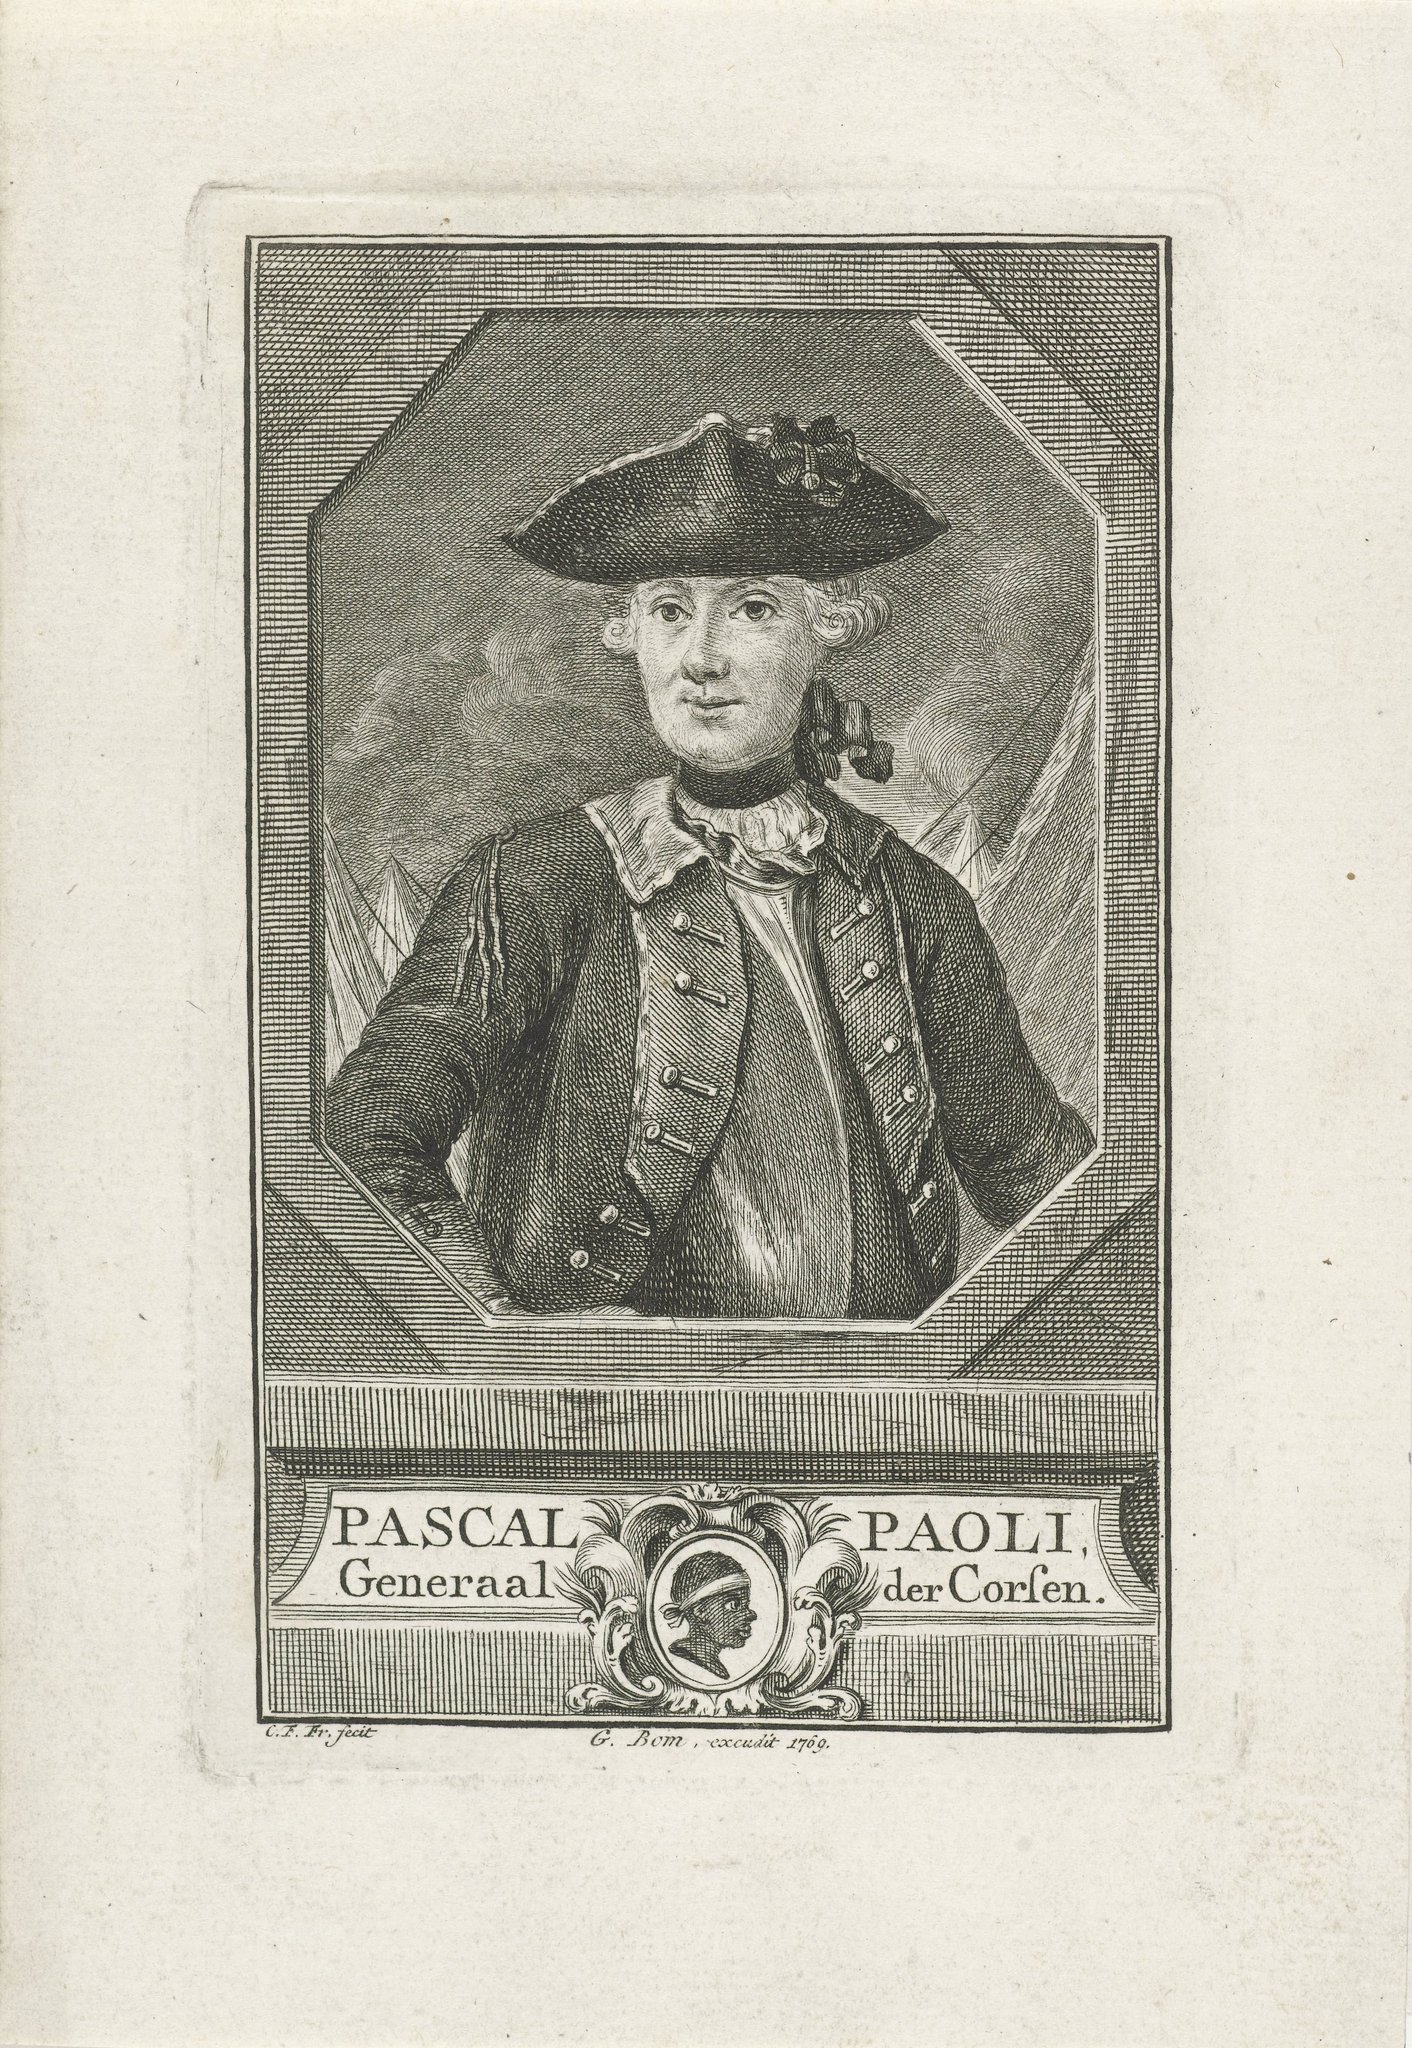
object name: print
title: Portret van Pascal Paoli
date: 1769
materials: paper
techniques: engraving, etching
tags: london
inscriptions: collector's mark: Lugt 2228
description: Portretbuste in achthoek van generaal Pascal Paoli met steek op het hoofd. Onder het portret staan op een sokkel zijn naam, titel en een cartouche met het gezicht van een donkere man en profil.